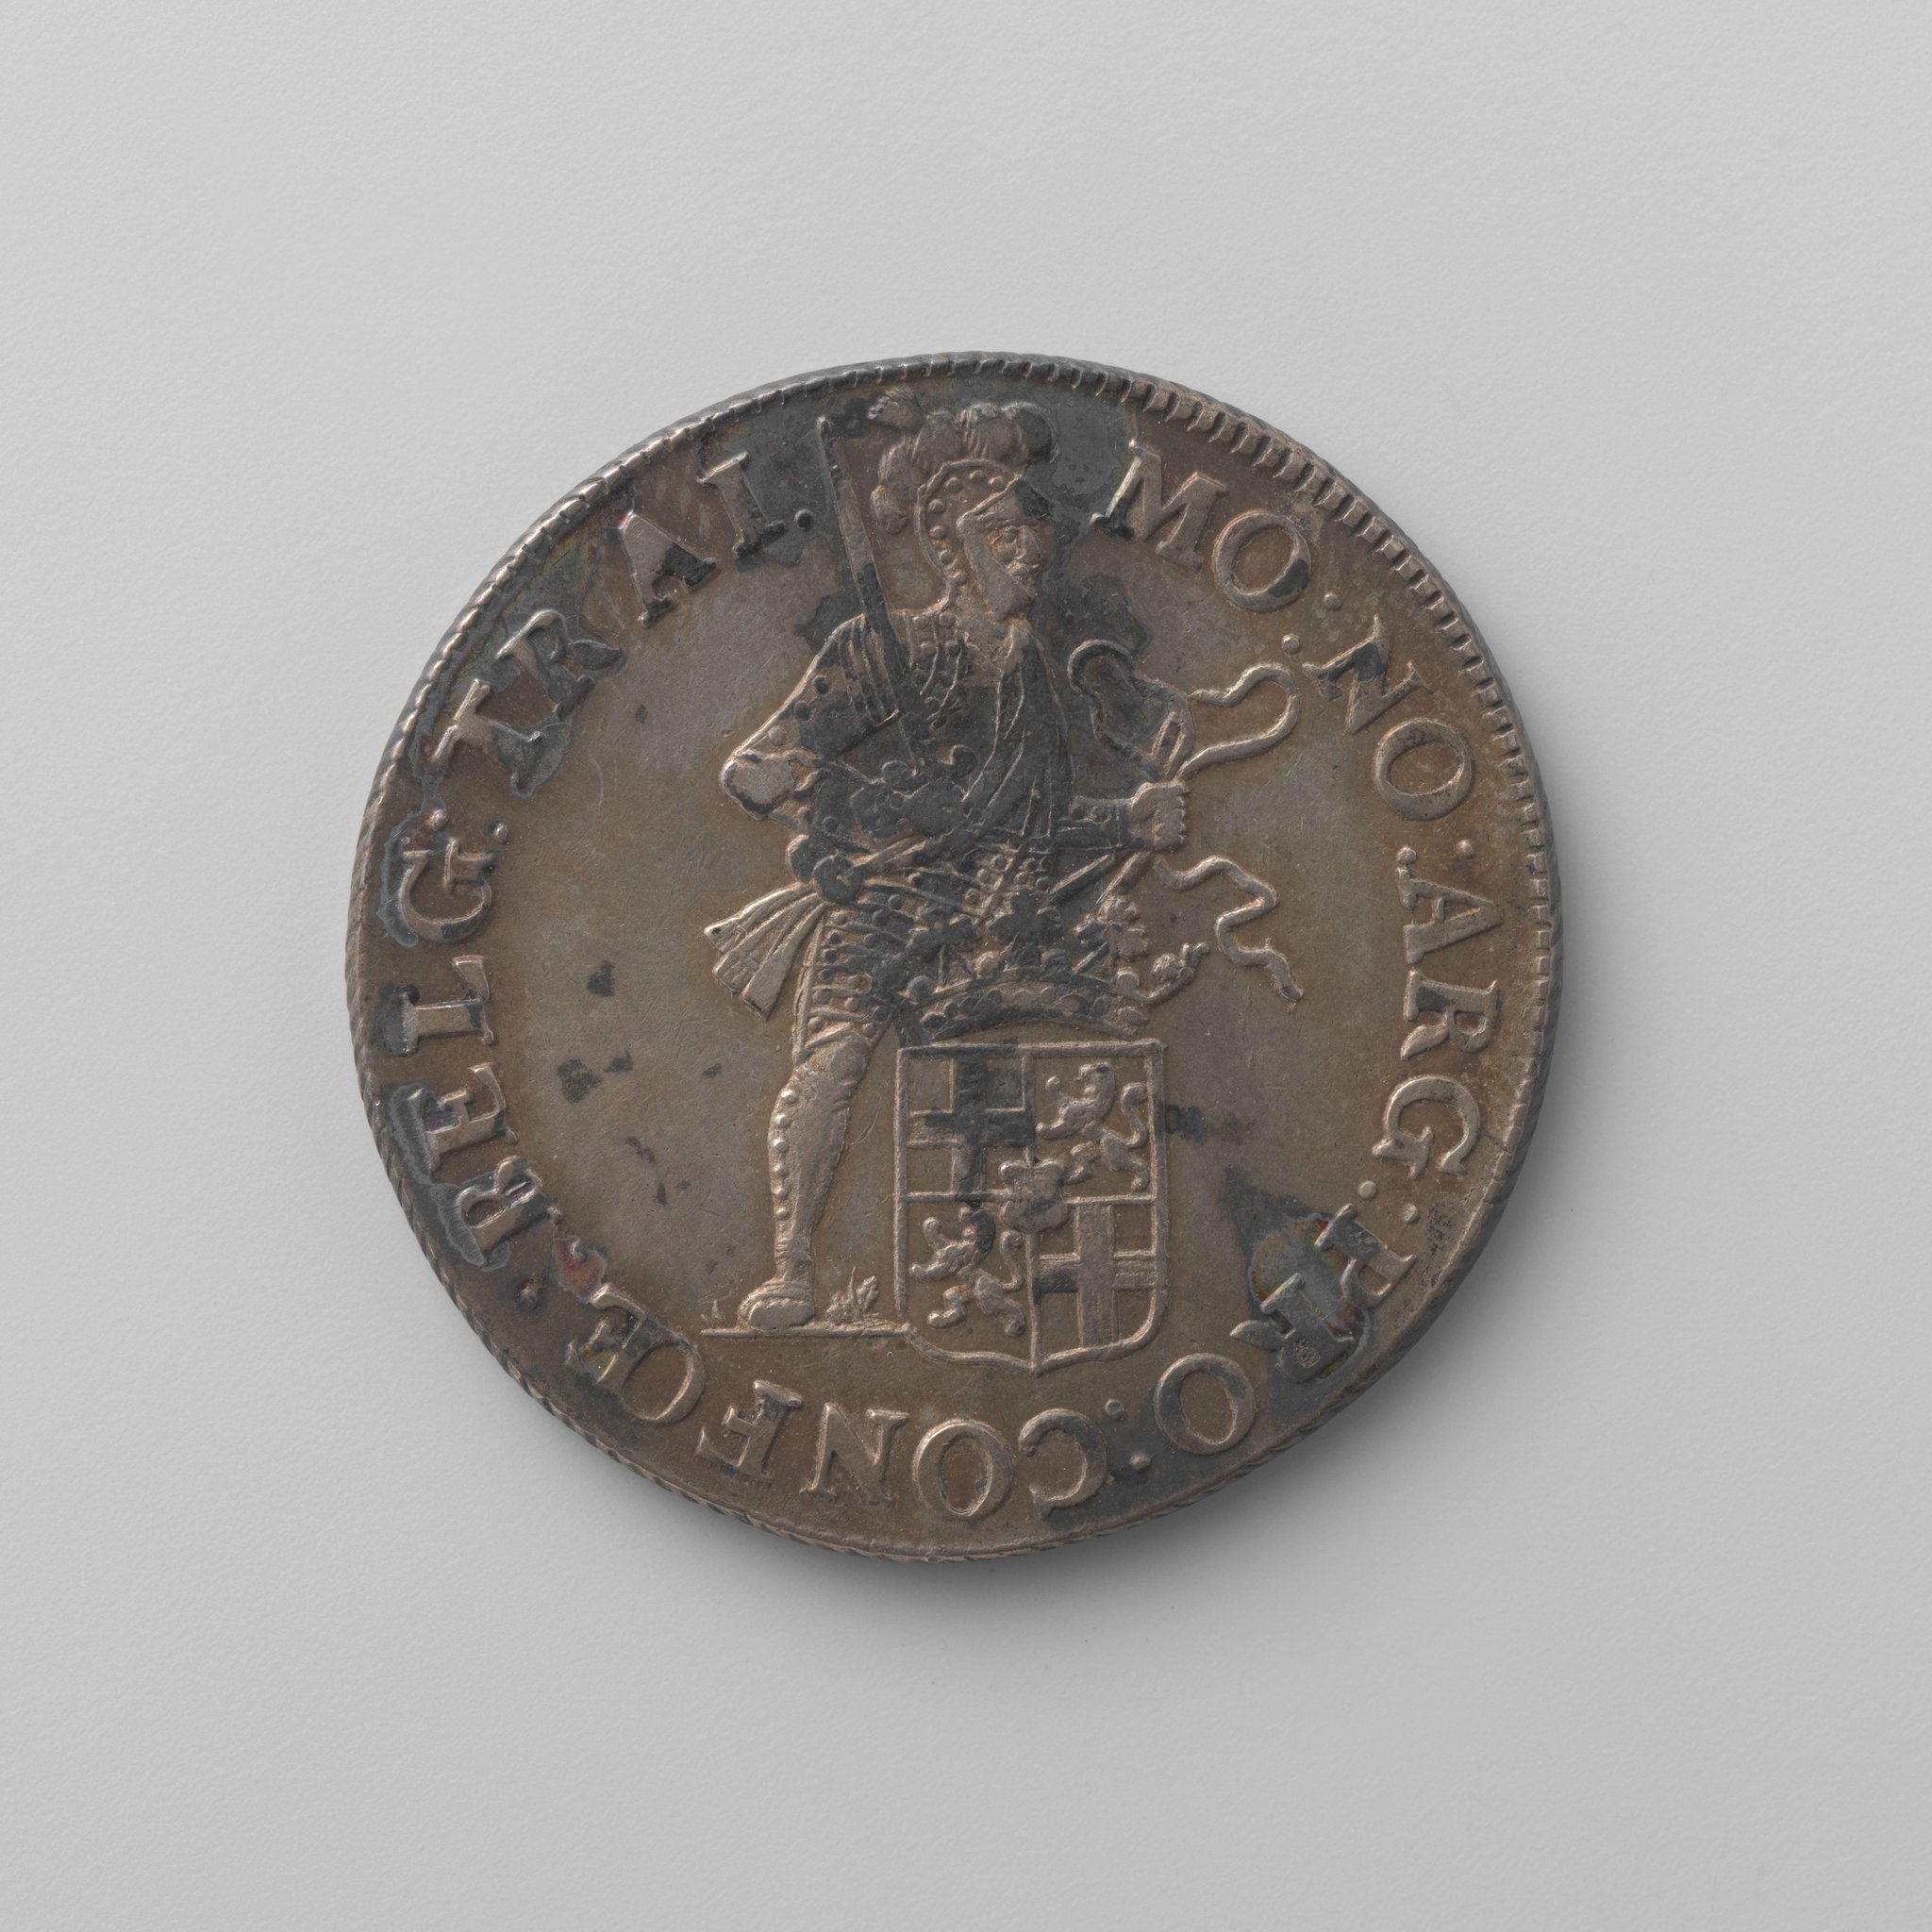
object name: zilveren dukaat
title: Utrecht, zilveren dukaat, 1805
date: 1805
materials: silver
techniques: striking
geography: utrecht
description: Zilveren munt. Voorzijde:staande geharnaste ridder naar rechts met zwaard in rechterhand en gekroond wapenschild van Utrecht aan lint in linkerhand. Keerzijde: tussen jaartal gekroond generaliteitswapenschild. Kabelrand.